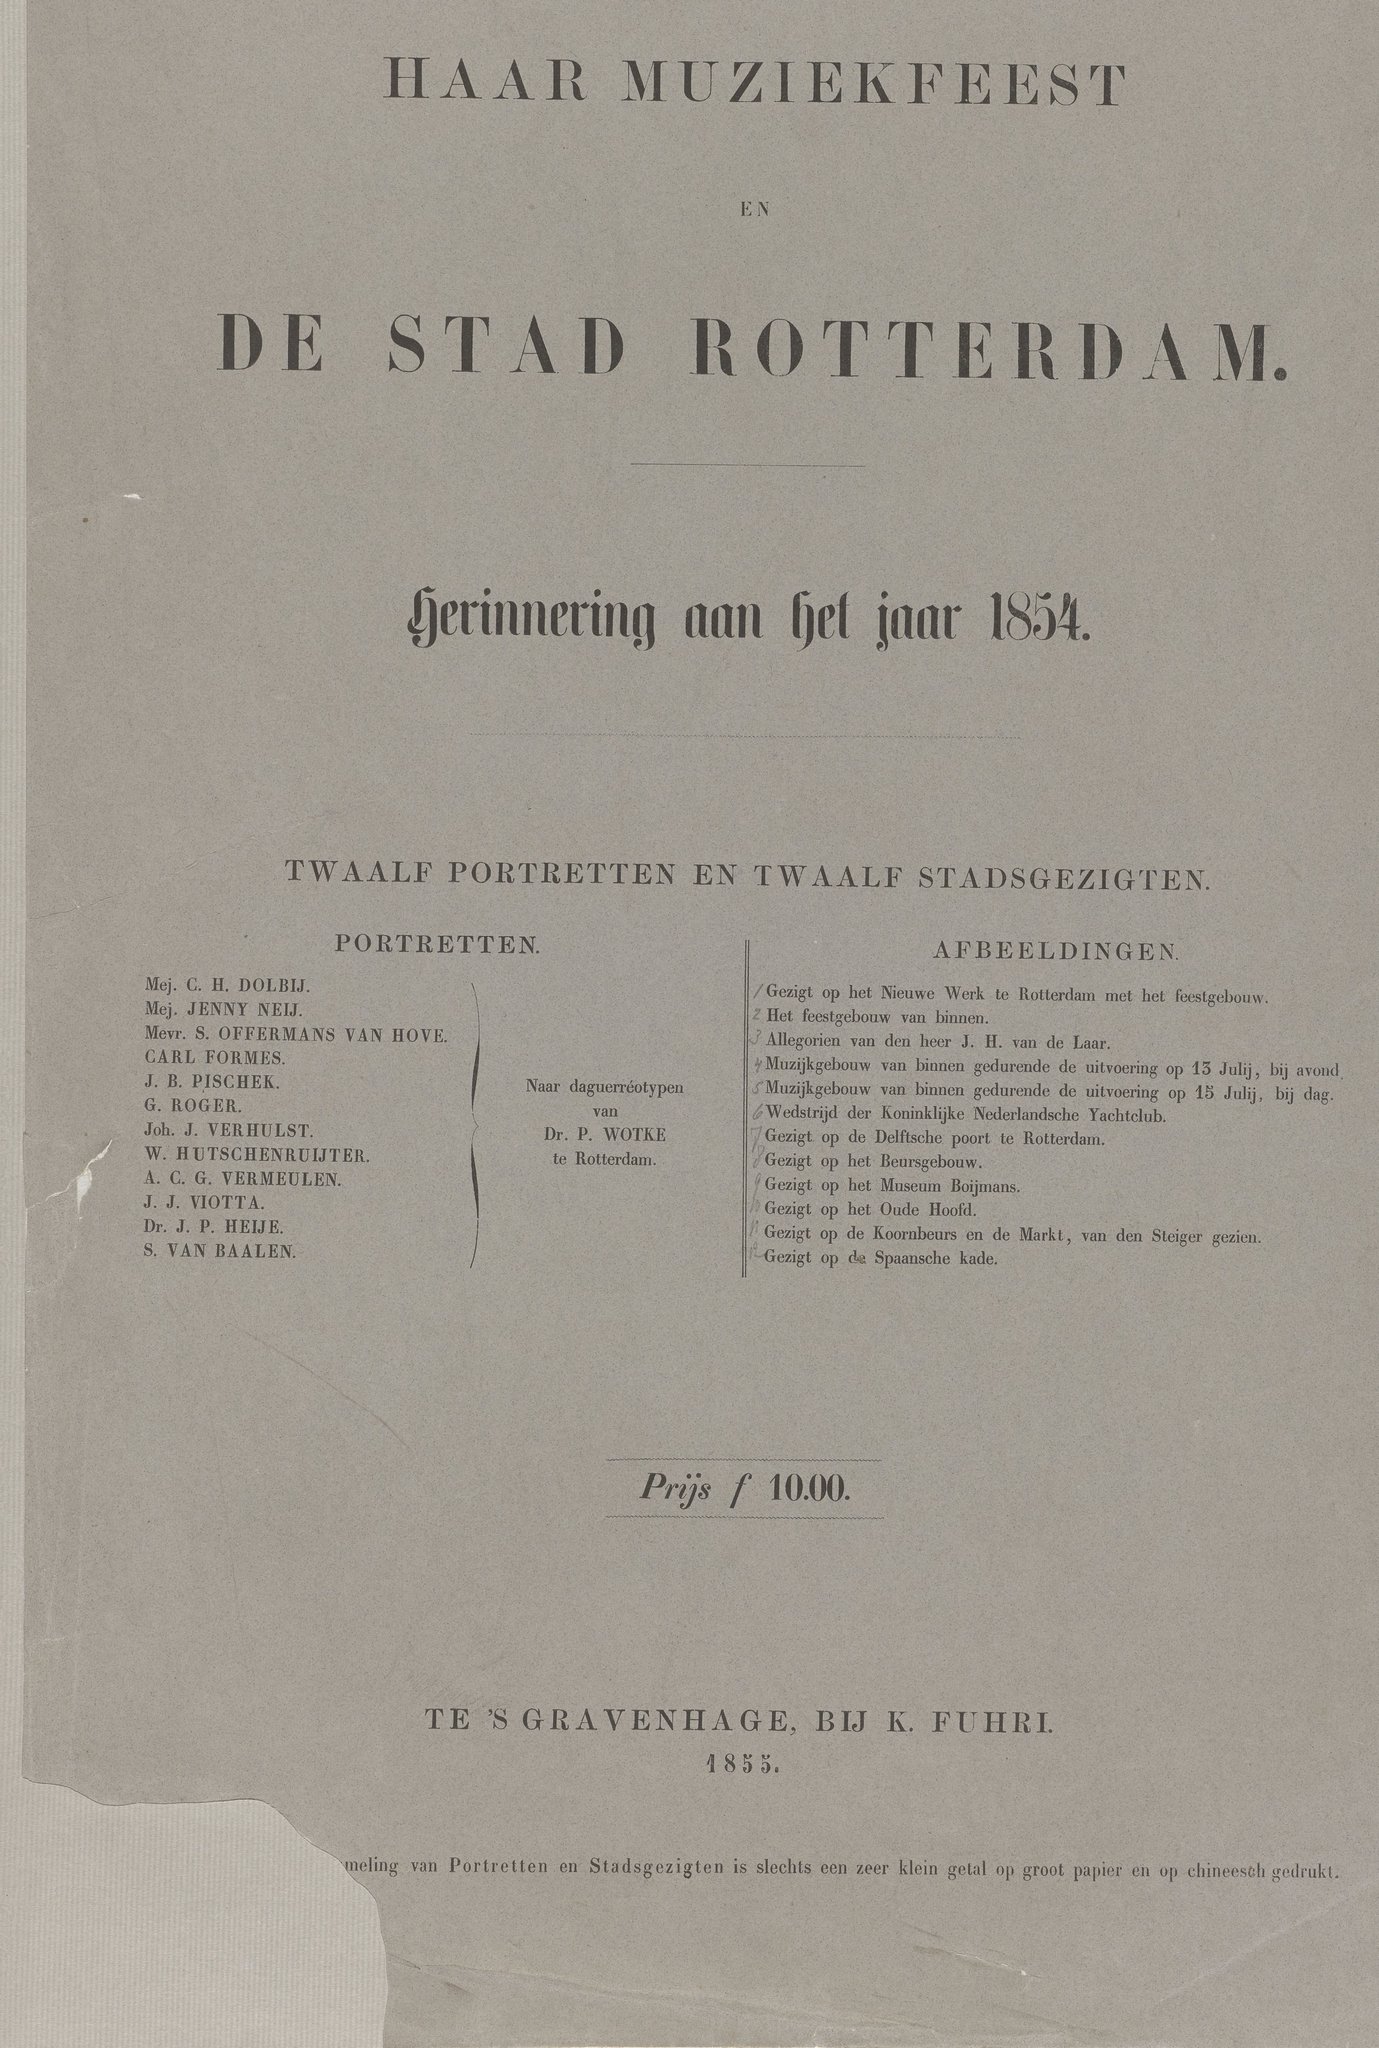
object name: wrapper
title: De Maatschappij ter Bevordering van Toonkunst, haar Muziekfeest en de stad Rotterdam. herinnering aan het jaar 1854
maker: koenraad fuhri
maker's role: bookseller, printer, publisher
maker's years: 1814-1858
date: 1855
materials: paper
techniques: letterpress printing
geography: the hague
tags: rotterdam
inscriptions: date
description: Omslag met een serie van twaalf portretten en twaalf stadsgezichten. Ter gelegenheid van het Muziekfeest ter viering van het 25-jarige bestaan van de Maatschappij ter Bevordering van Toonkunst in Rotterdam, 12-15 juli 1854.